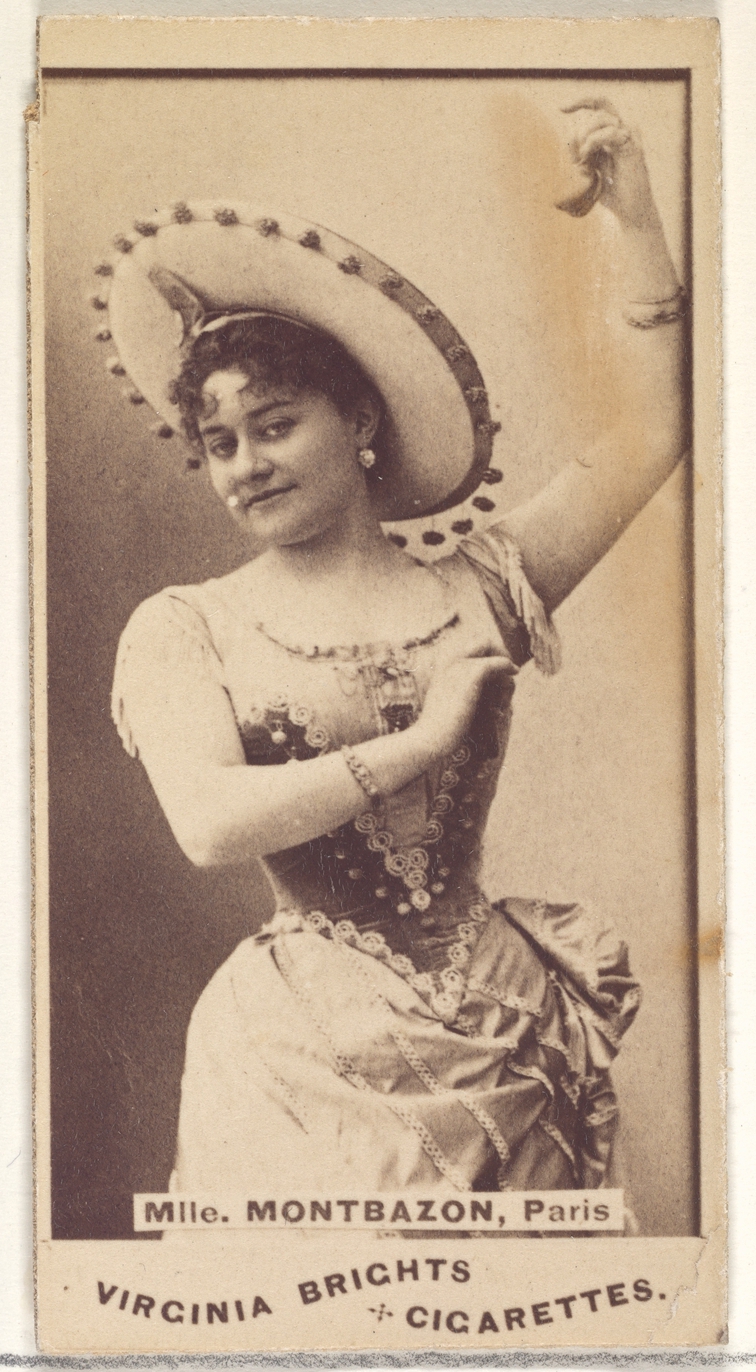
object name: photograph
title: Mlle. Montbazon, Paris, from the Actors and Actresses series (N45, Type 1) for Virginia Brights Cigarettes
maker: allen & ginter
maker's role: publisher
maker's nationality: american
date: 1888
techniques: albumen silver print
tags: portraits,women,actresses